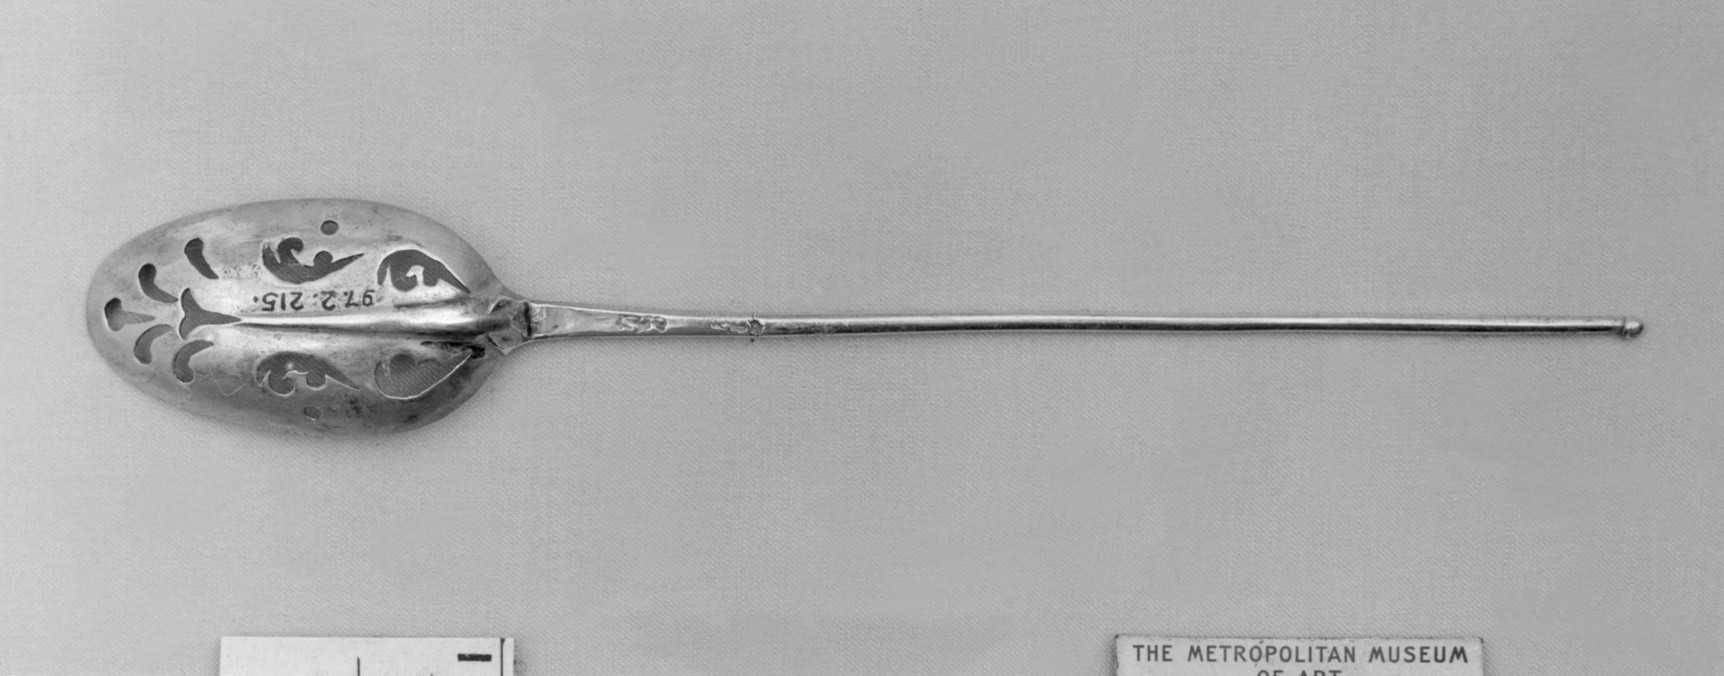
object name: strainer spoon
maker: s. t.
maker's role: maker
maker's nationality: british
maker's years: 1700-1750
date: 1701-1750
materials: silver